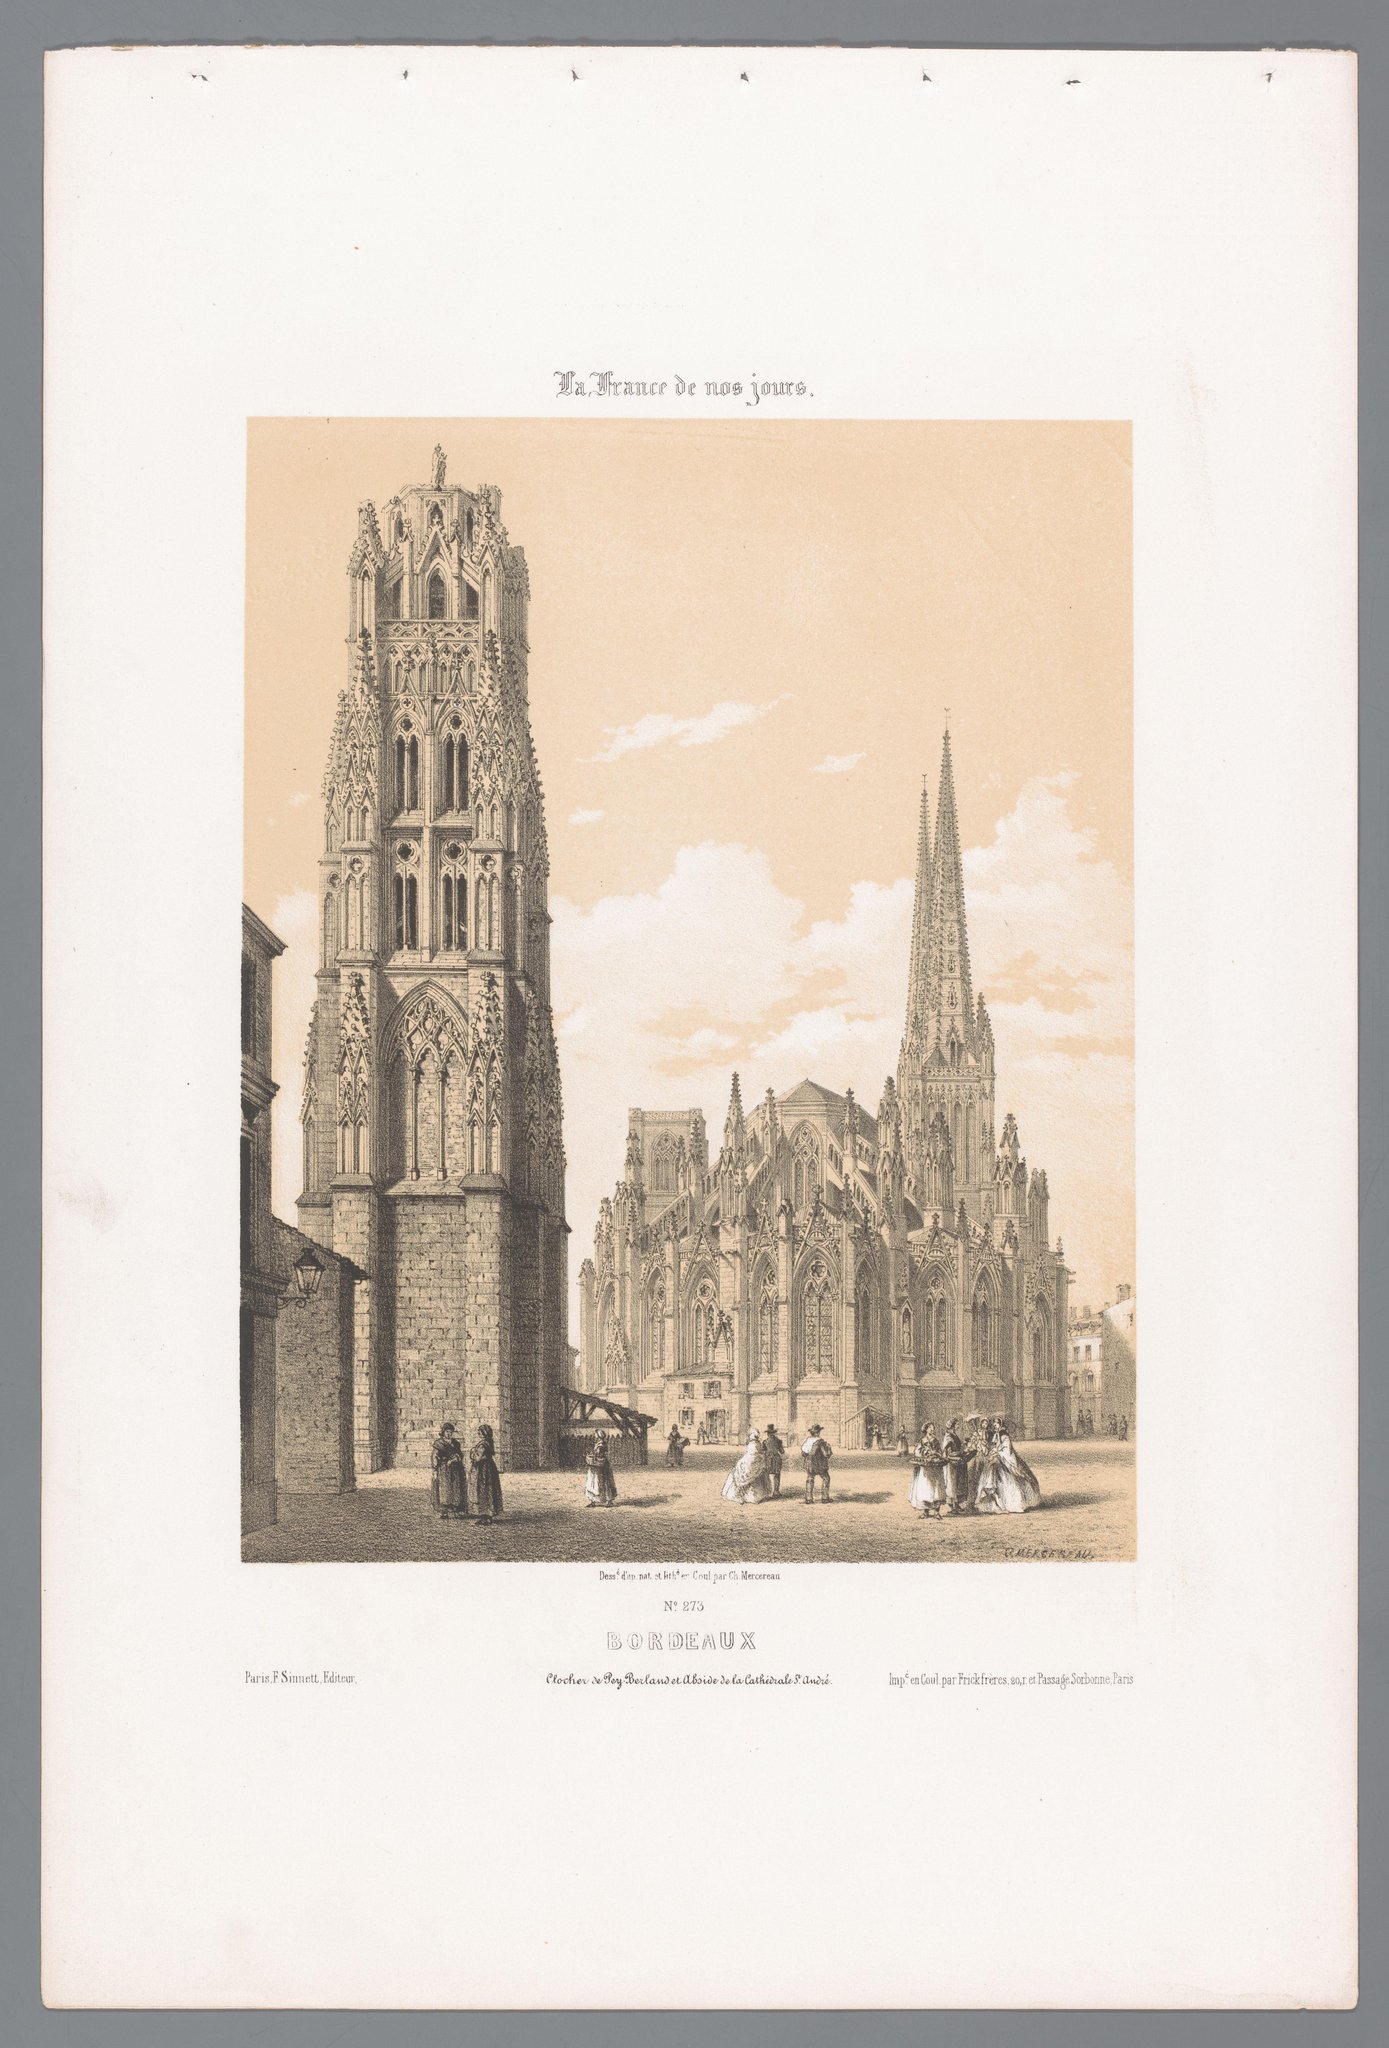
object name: print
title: Bordeaux, clocher de Pey-Berland et abside de la Cathédrale St. André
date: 1856-1874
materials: paper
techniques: tone lithography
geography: paris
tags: city-view, and landscape with man-made constructions, tower, clock tower ~ monumental adornment, church (exterior)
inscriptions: collector's mark: Lugt 2228